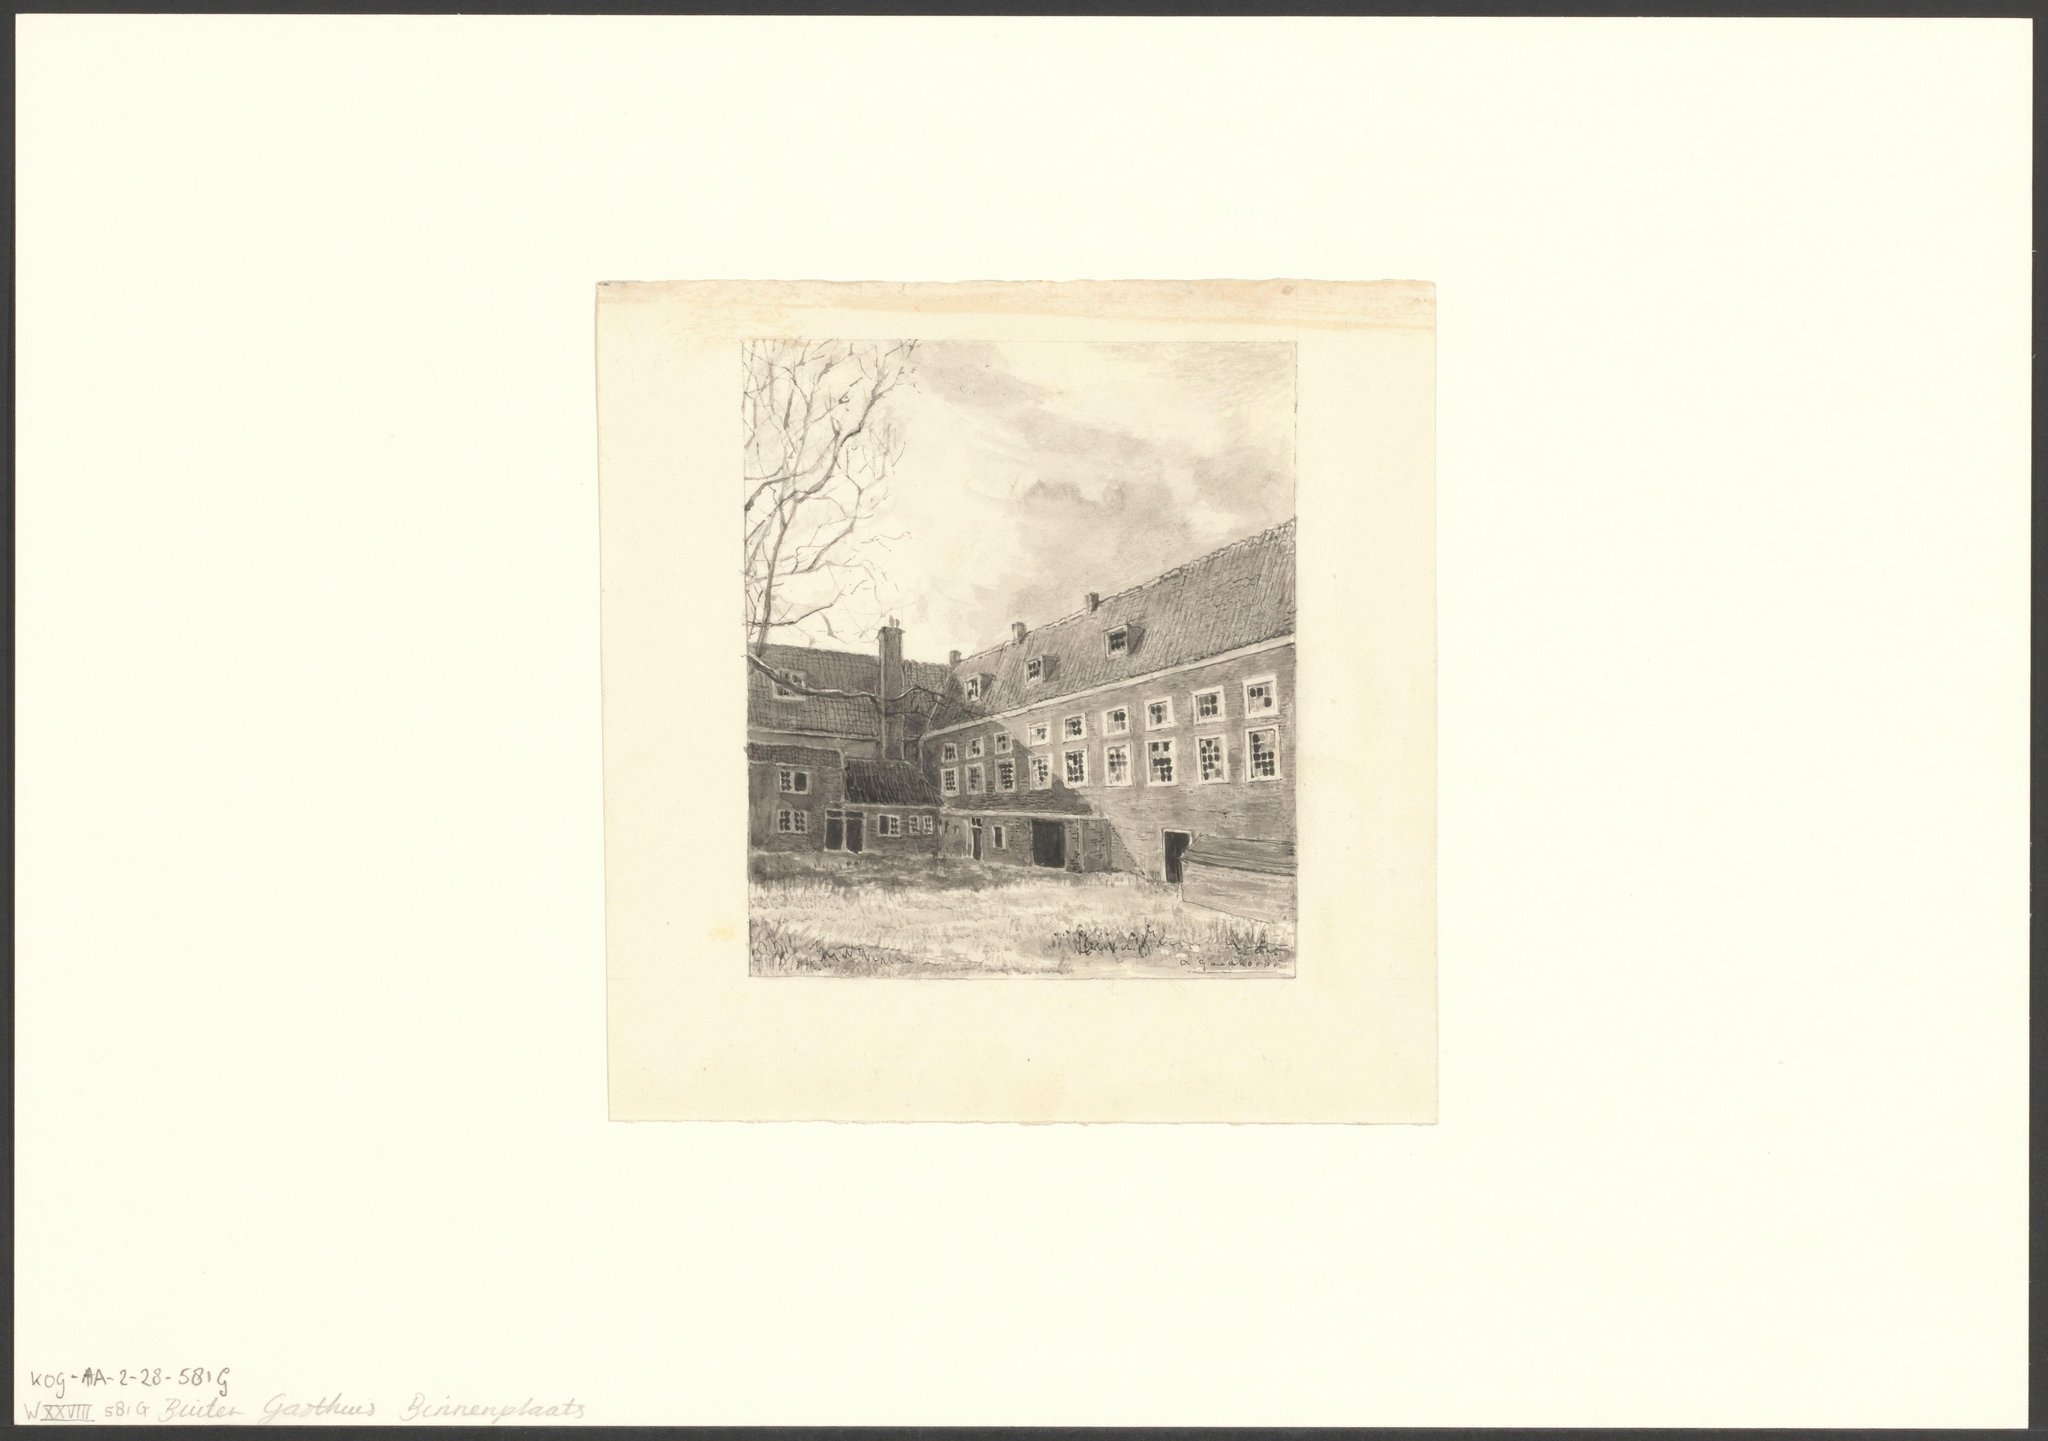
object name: drawing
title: Gezicht op de binnenplaats van het Buitengasthuis aan de Overtoom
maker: goedkoop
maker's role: draughtsman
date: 1850-1950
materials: ink, paper, pencil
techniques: brush, pen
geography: amsterdam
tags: city-view in general; 'veduta', façade (of house or building)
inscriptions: signature: ‘a. goedkoop’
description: Tekening binnen de Atlas Van Eck ingedeeld op wijknummer 28.